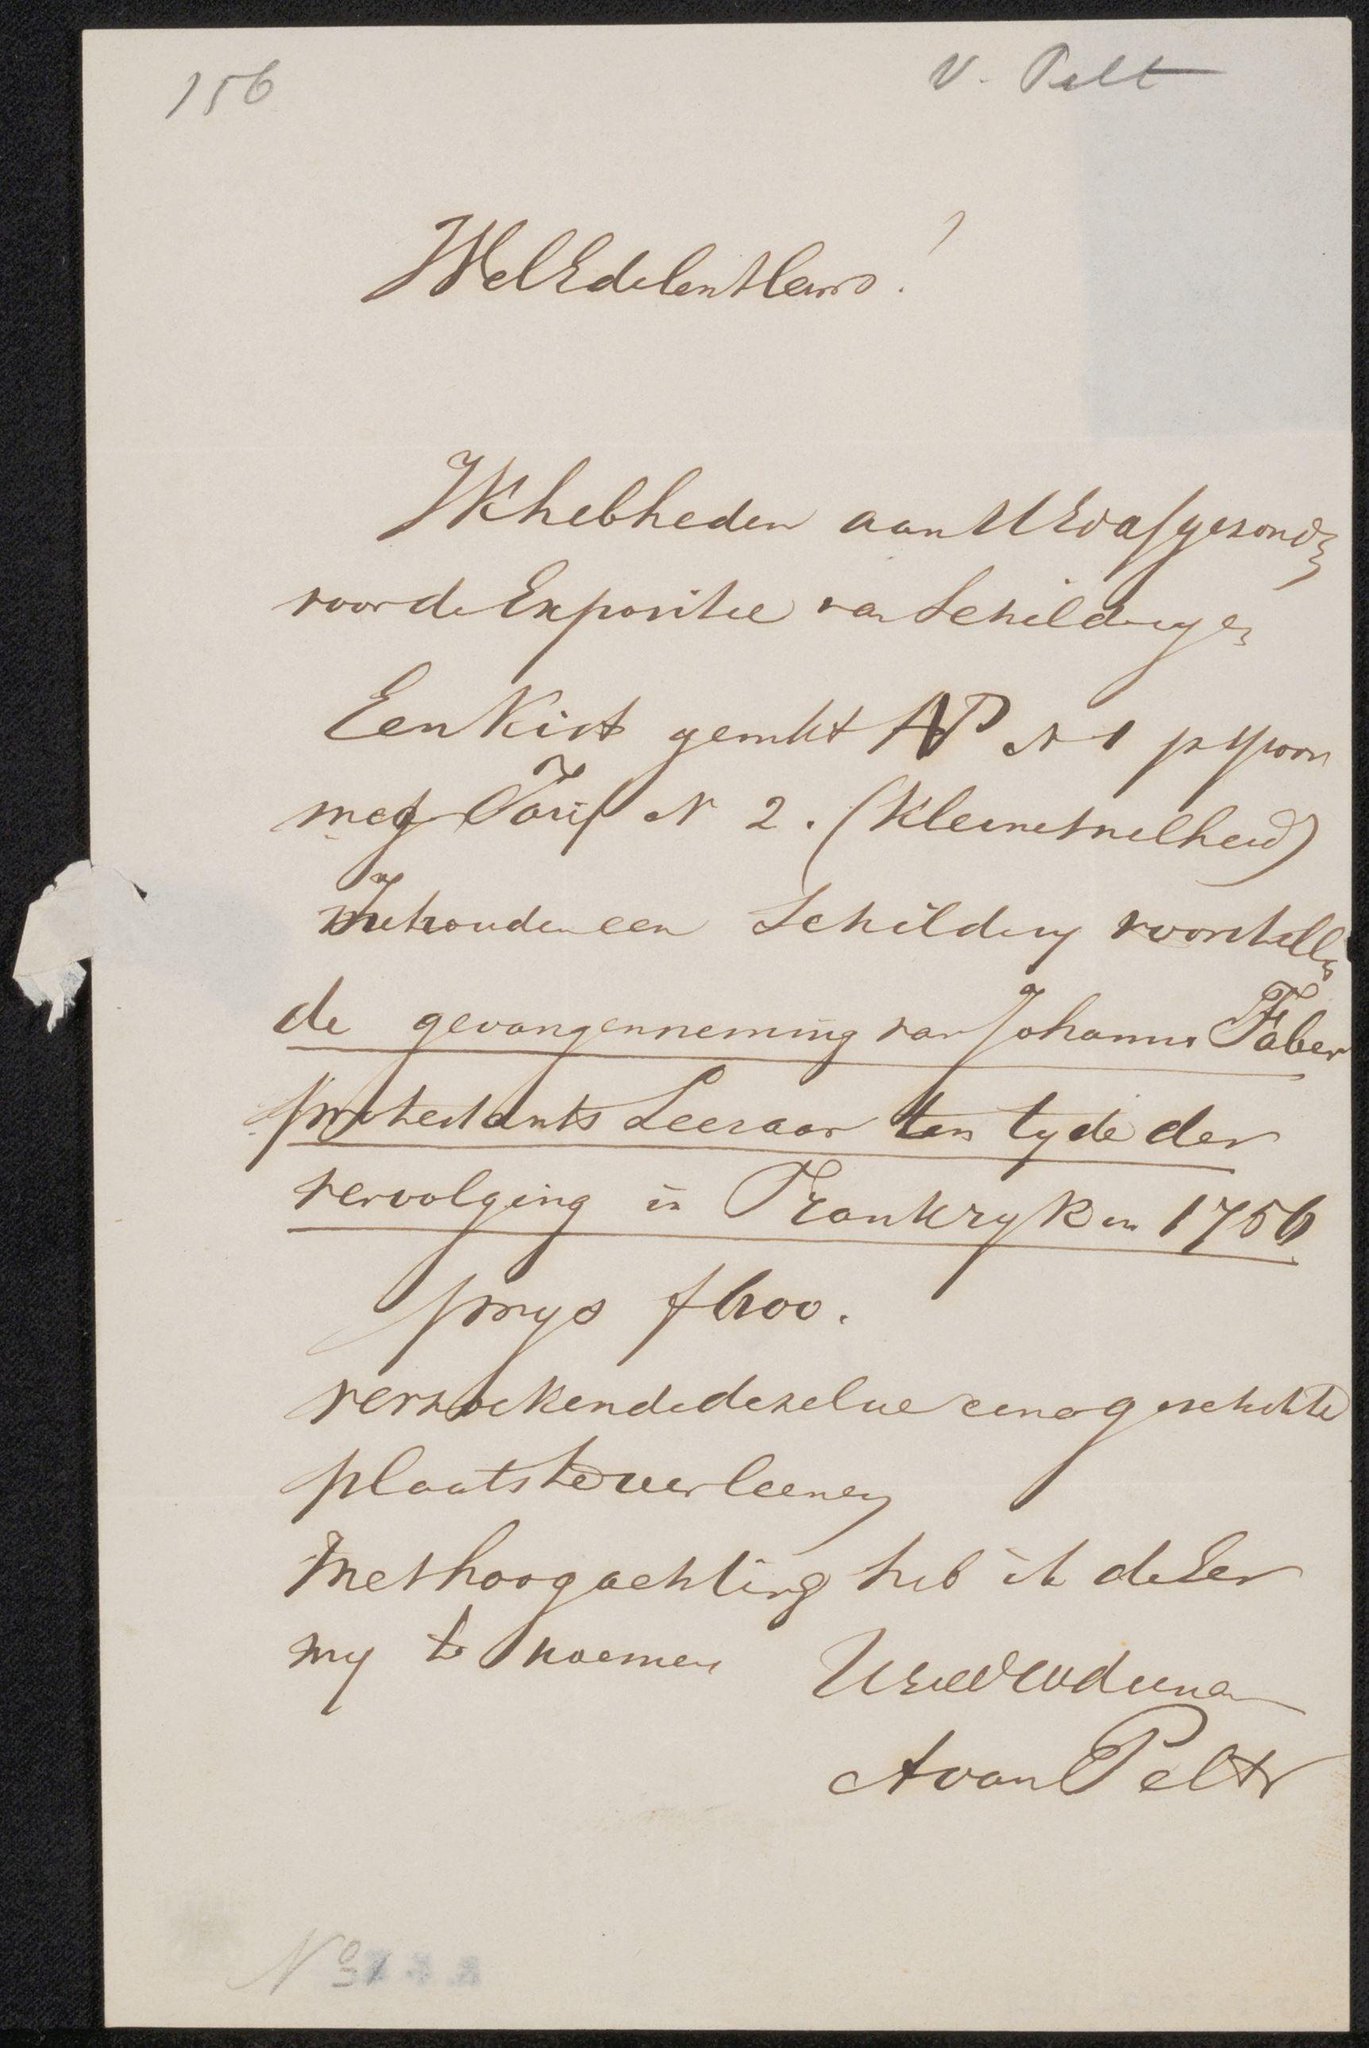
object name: letter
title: Brief aan Carel Vosmaer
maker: abraham van pelt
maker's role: draughtsman, print maker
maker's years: 1815-1895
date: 1861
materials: ink, paper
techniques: pen, writing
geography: amsterdam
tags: the hague, carel vosmaer, painting (including book-illumination, miniature-painting), exhibition ~ art, money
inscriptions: collector's mark: Lugt 2233